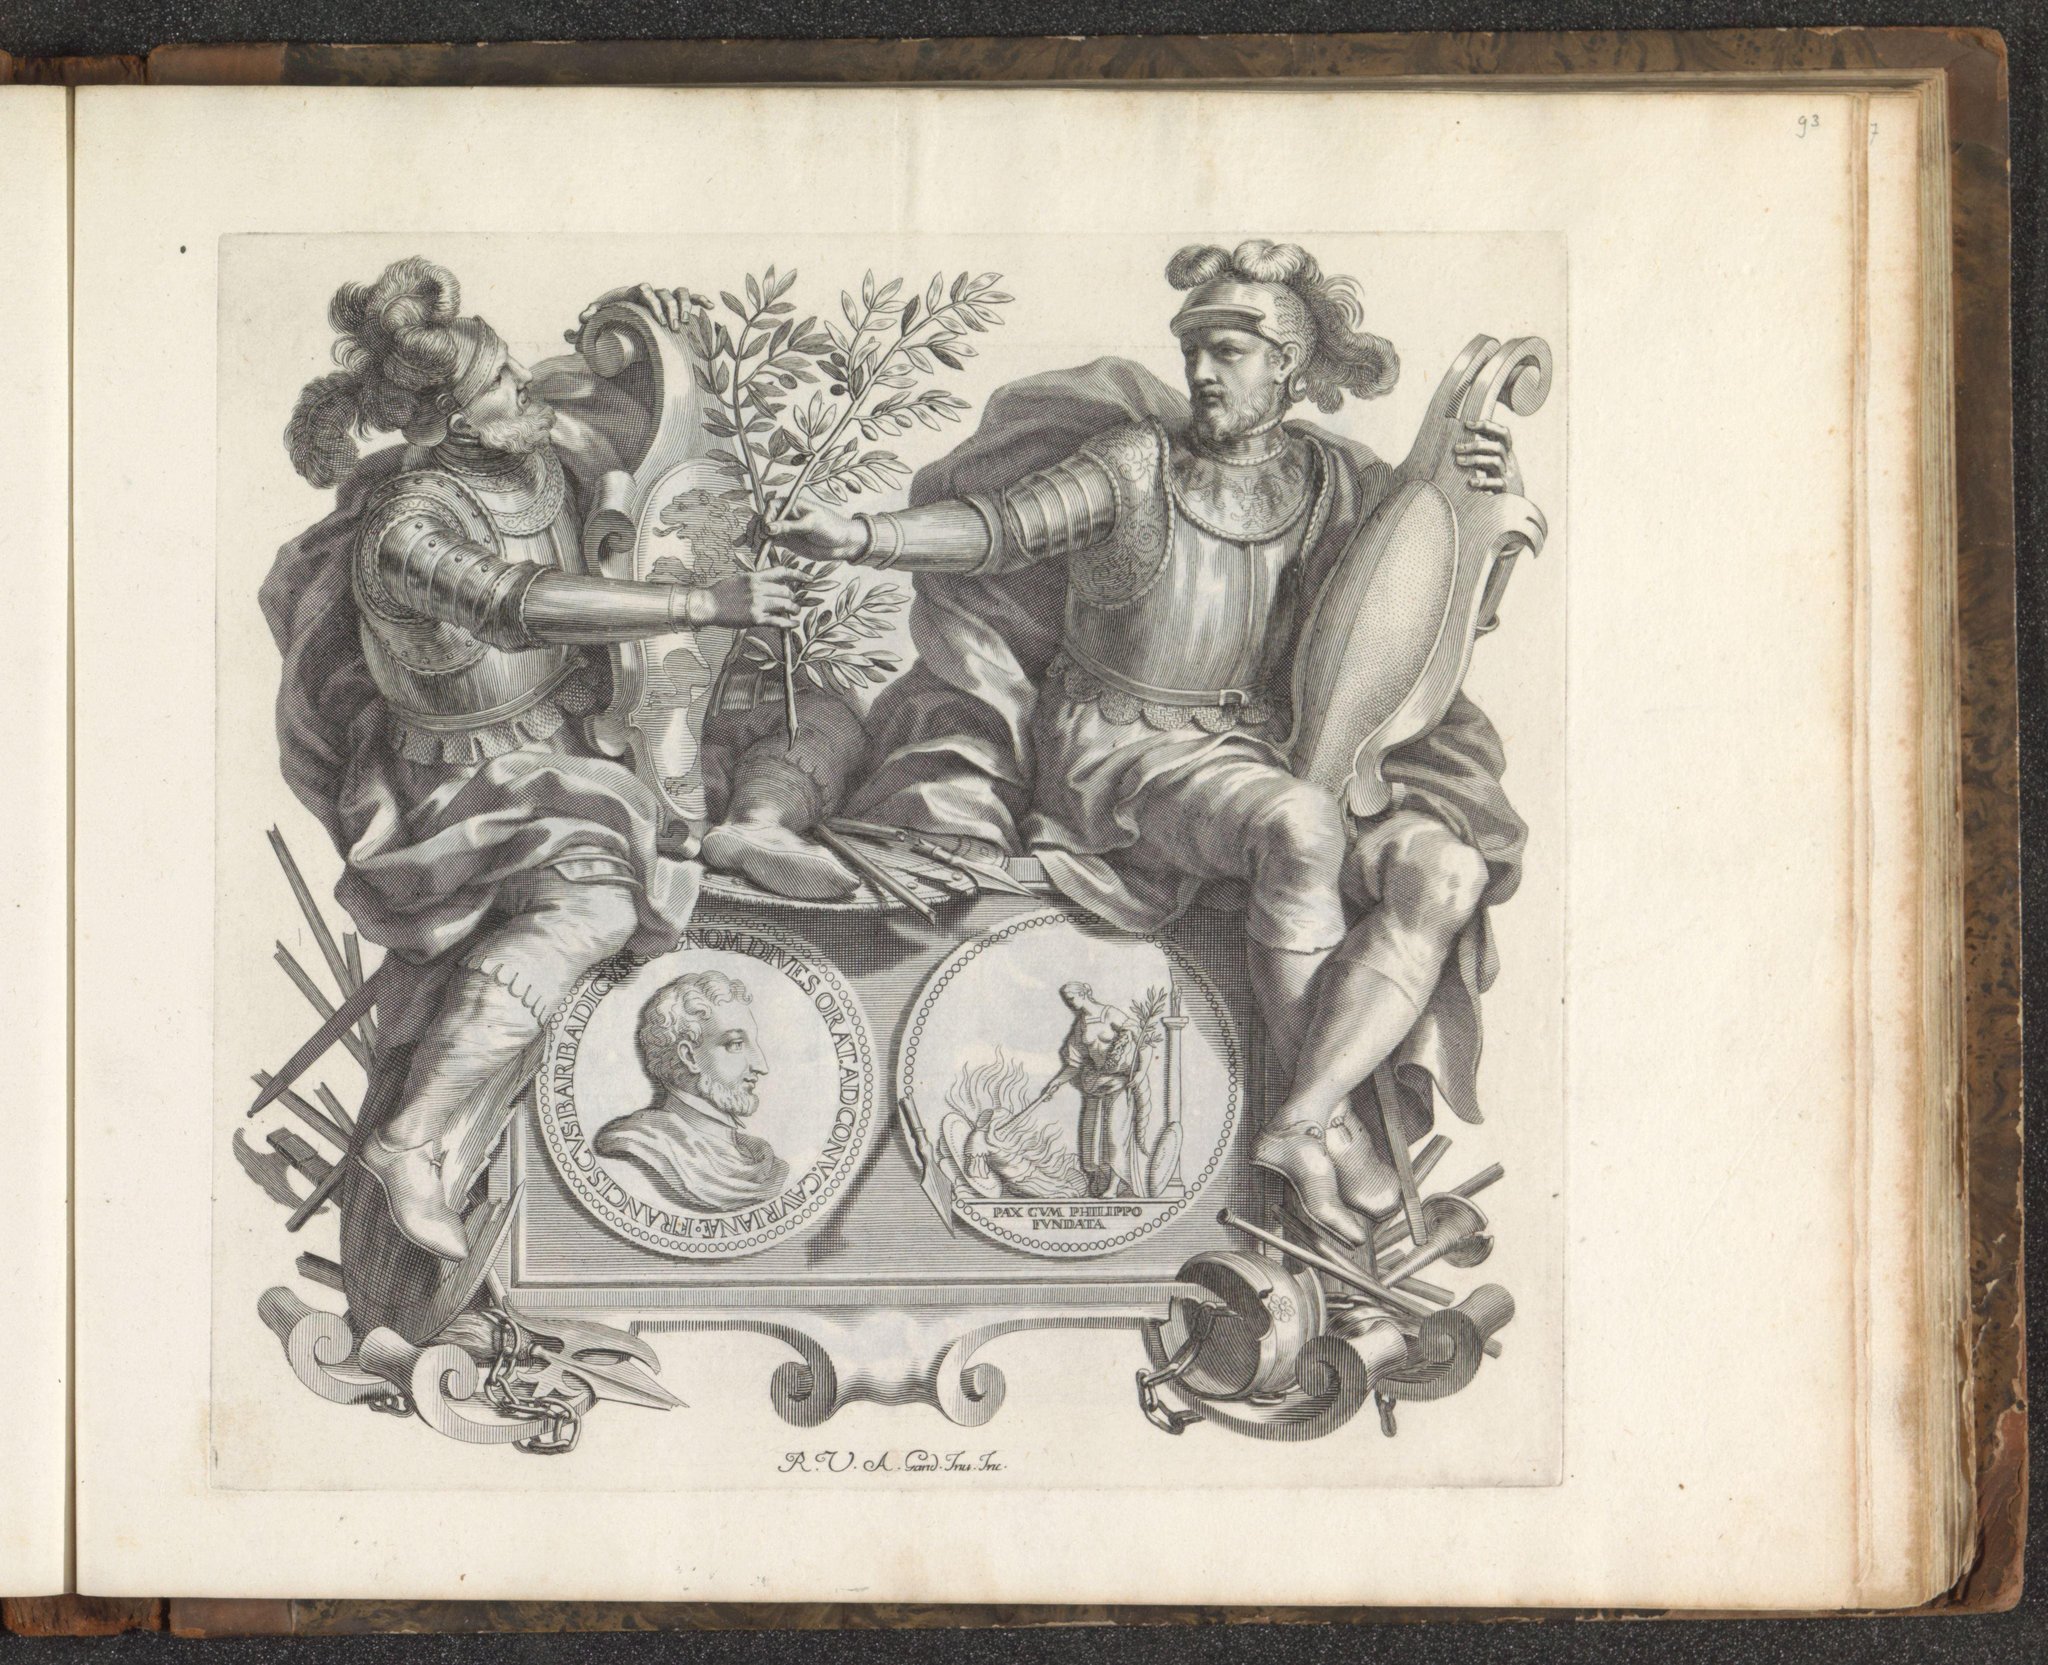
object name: album leaf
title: Numismata virorum illustrium ex Barbadica gente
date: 1673-1743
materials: paper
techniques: engraving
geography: rome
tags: coat of arms (as symbol of the state, etc.), symbols, allegories of peace, 'pax'; 'pace' (ripa), knight, venice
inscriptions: collector's mark: Lugt 2228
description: Voetstuk in de vorm van een cartouche. Daarop een medaillon met op de voorkant het portret van Francesco Barbarigo. Op de achterkant verbrandt Vrede een wapenuitrusting. Op het voetstuk zitten twee geharnaste mannen. Zij geven elkaar een lauriertak. De linker heeft een schild met het wapen van de Italiaanse provincie Brescia in zijn handen. De rechter heeft het wapen van de Italiaans provincie Bergamo vast. Brescia en Bergamo kwamen in de vijftiende eeuw onder Venetiaans bestuur. De prent maakt deel uit van een album.